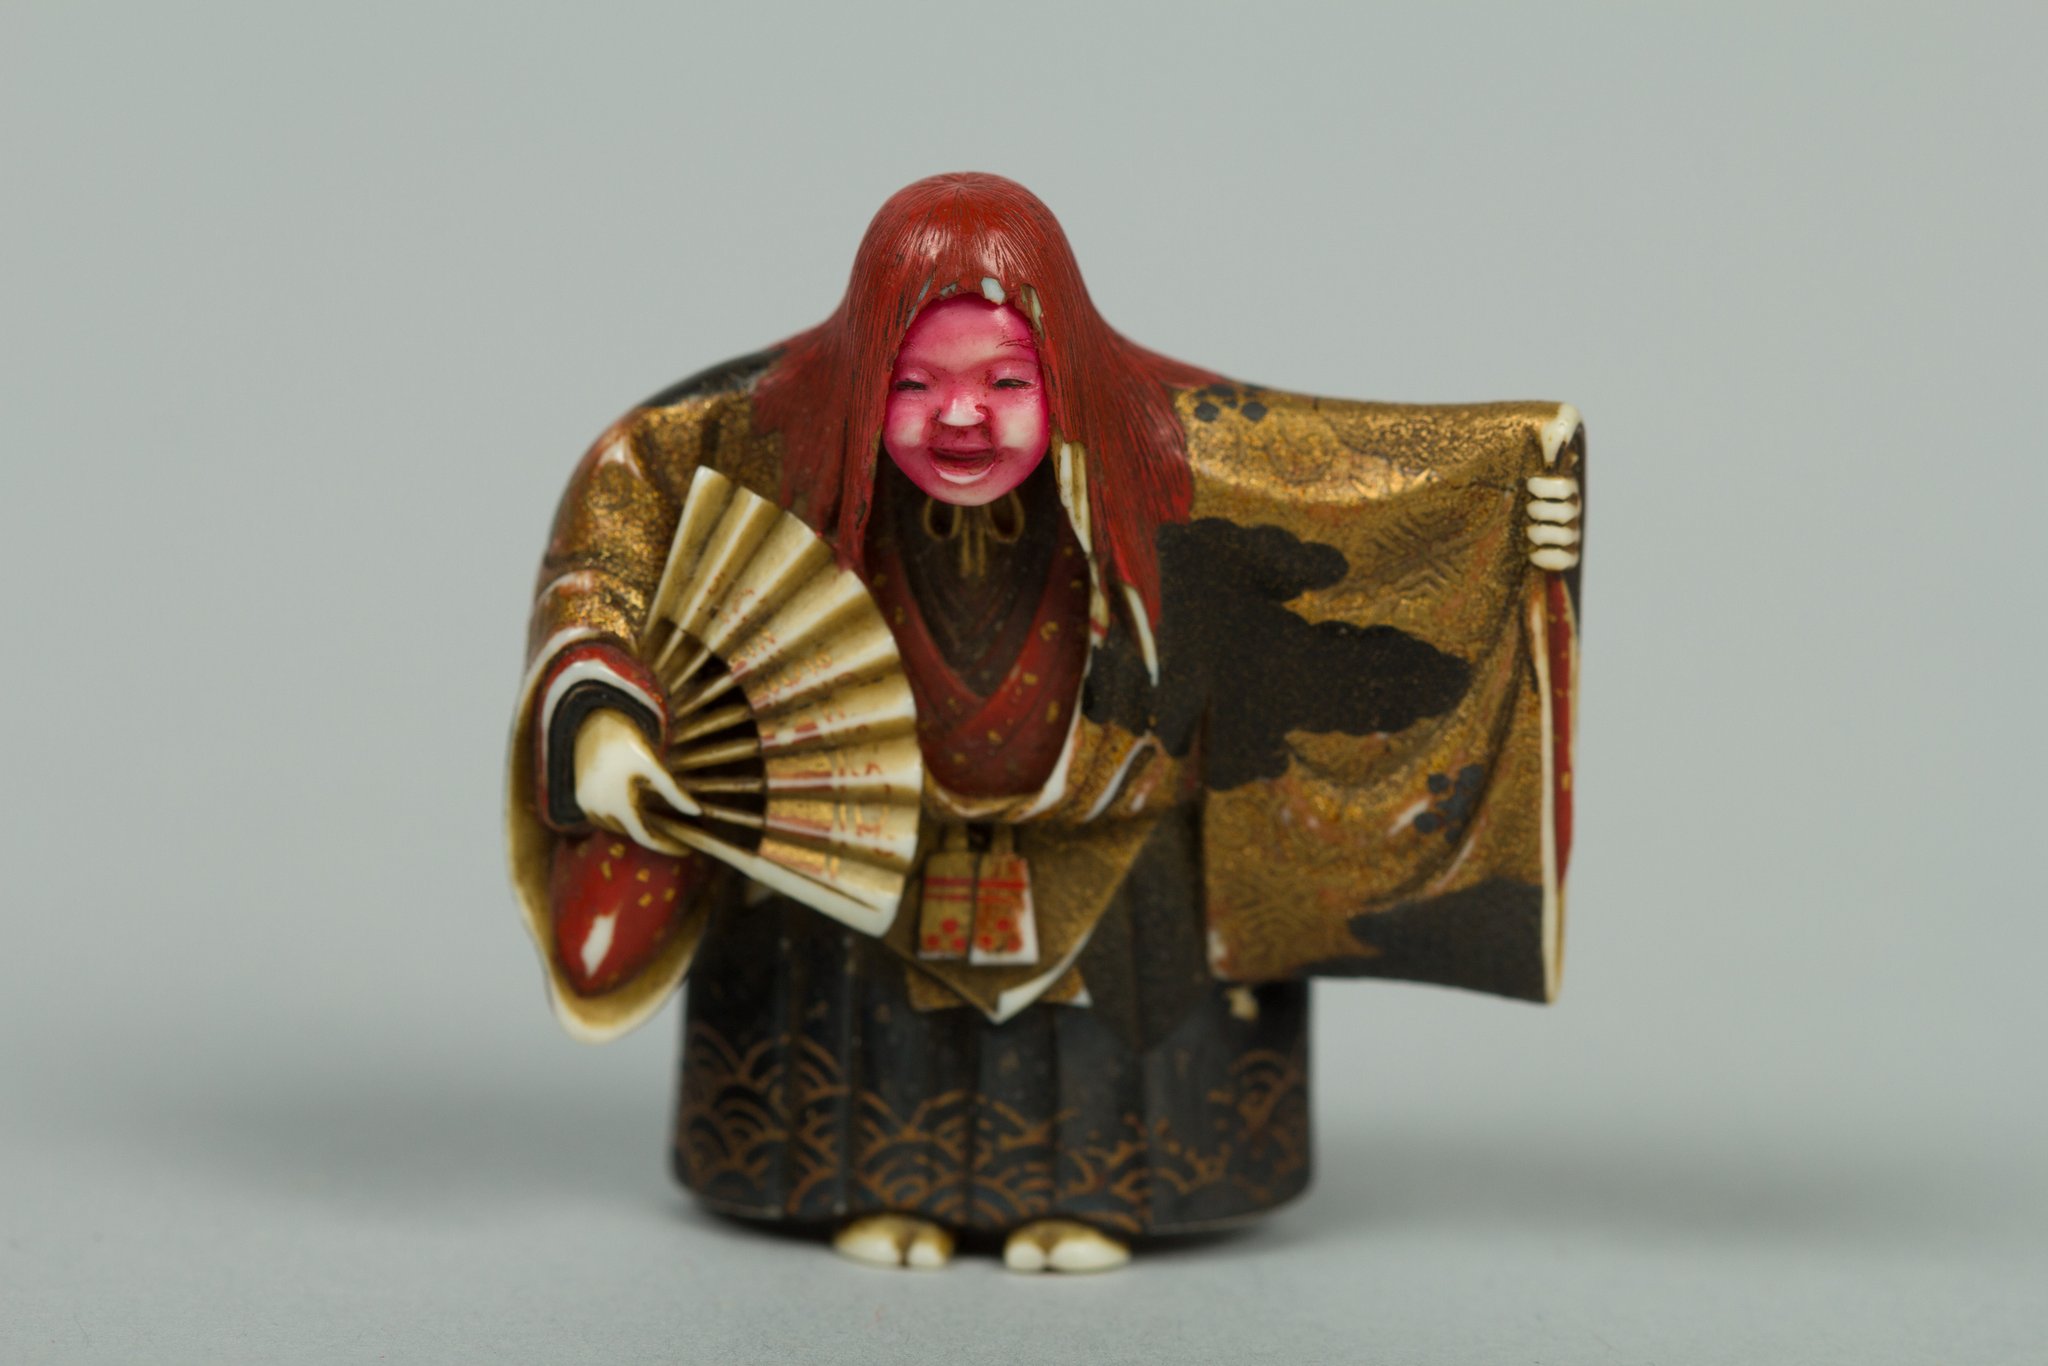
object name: netsuke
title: Netsuke of Shōjō Dancer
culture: japanese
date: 1834-1866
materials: gold, ivory, silver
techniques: hiramakie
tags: fans,dancers